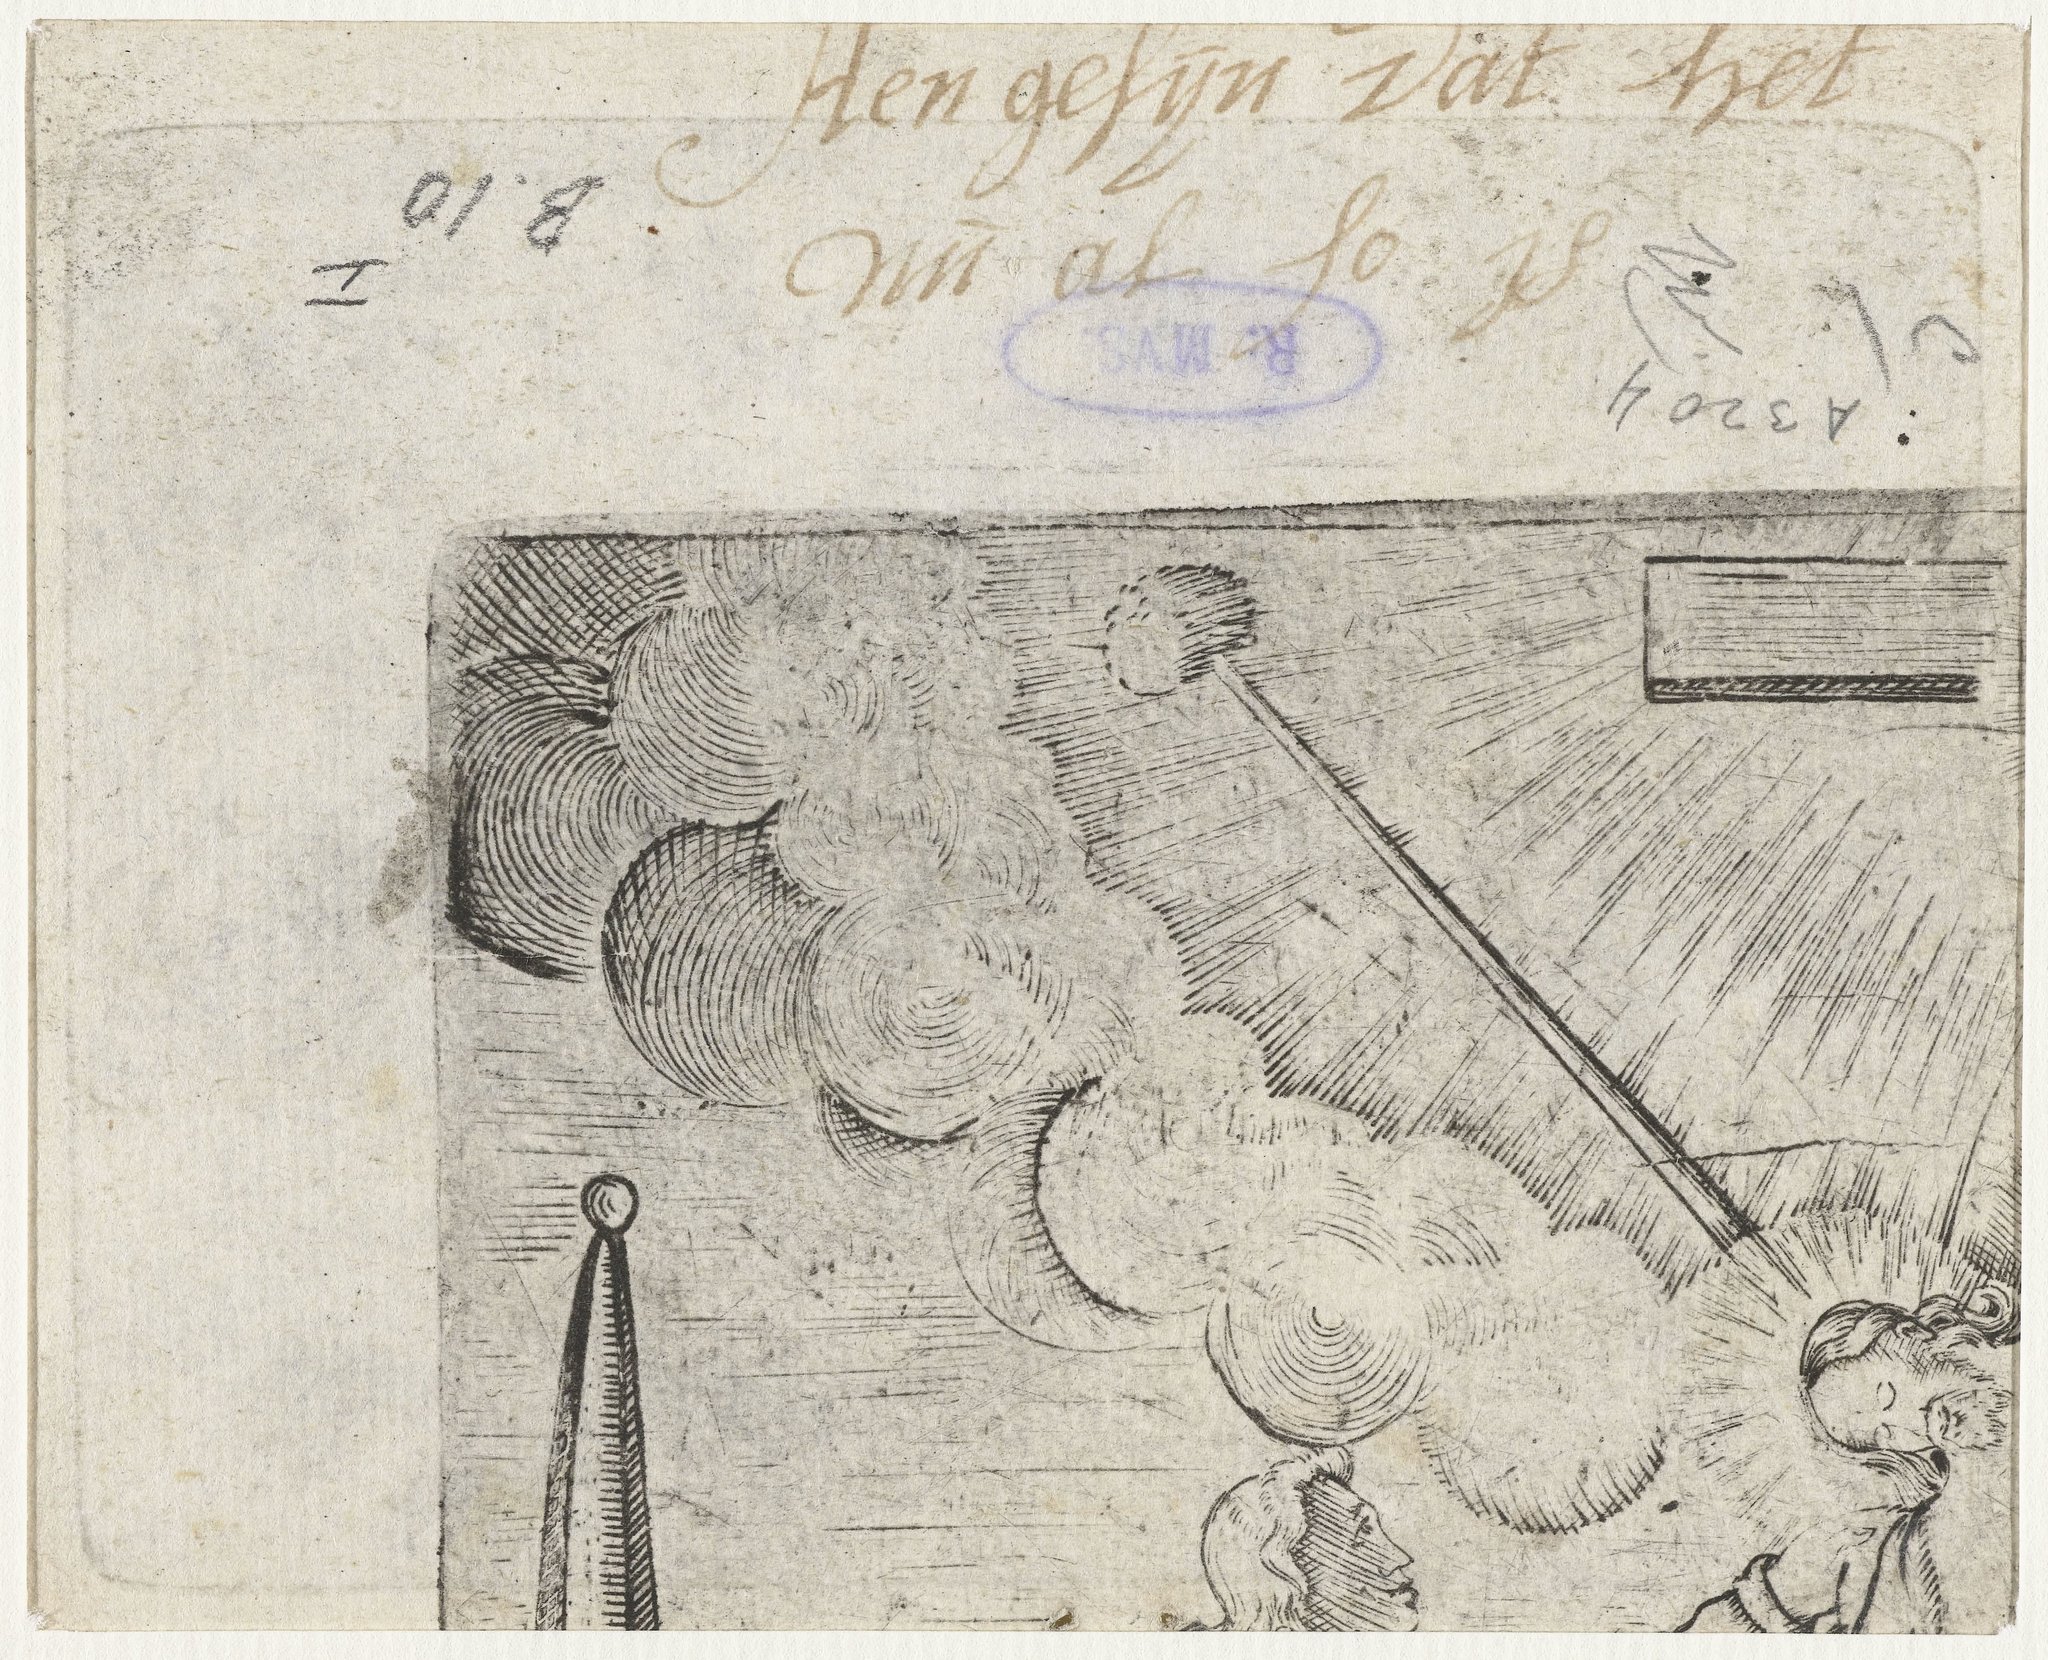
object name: print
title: Kruisafname van Christus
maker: Anonymous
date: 1550-1673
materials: paper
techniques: engraving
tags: descent from the cross: christ is taken down from the cross, usually by nicodemus and joseph of arimathaea who are standing on the ladders (both arms of christ detached), single instruments of the passion (with name)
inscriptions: inscription: ‘Het gesijn dat het nu al so is’, collector's mark: Lugt 2228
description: Linkerbovenhoek van een voorstelling met Christus die van het kruis wordt gehaald. Spons op een stok achter hem binnen een stralenkrans.